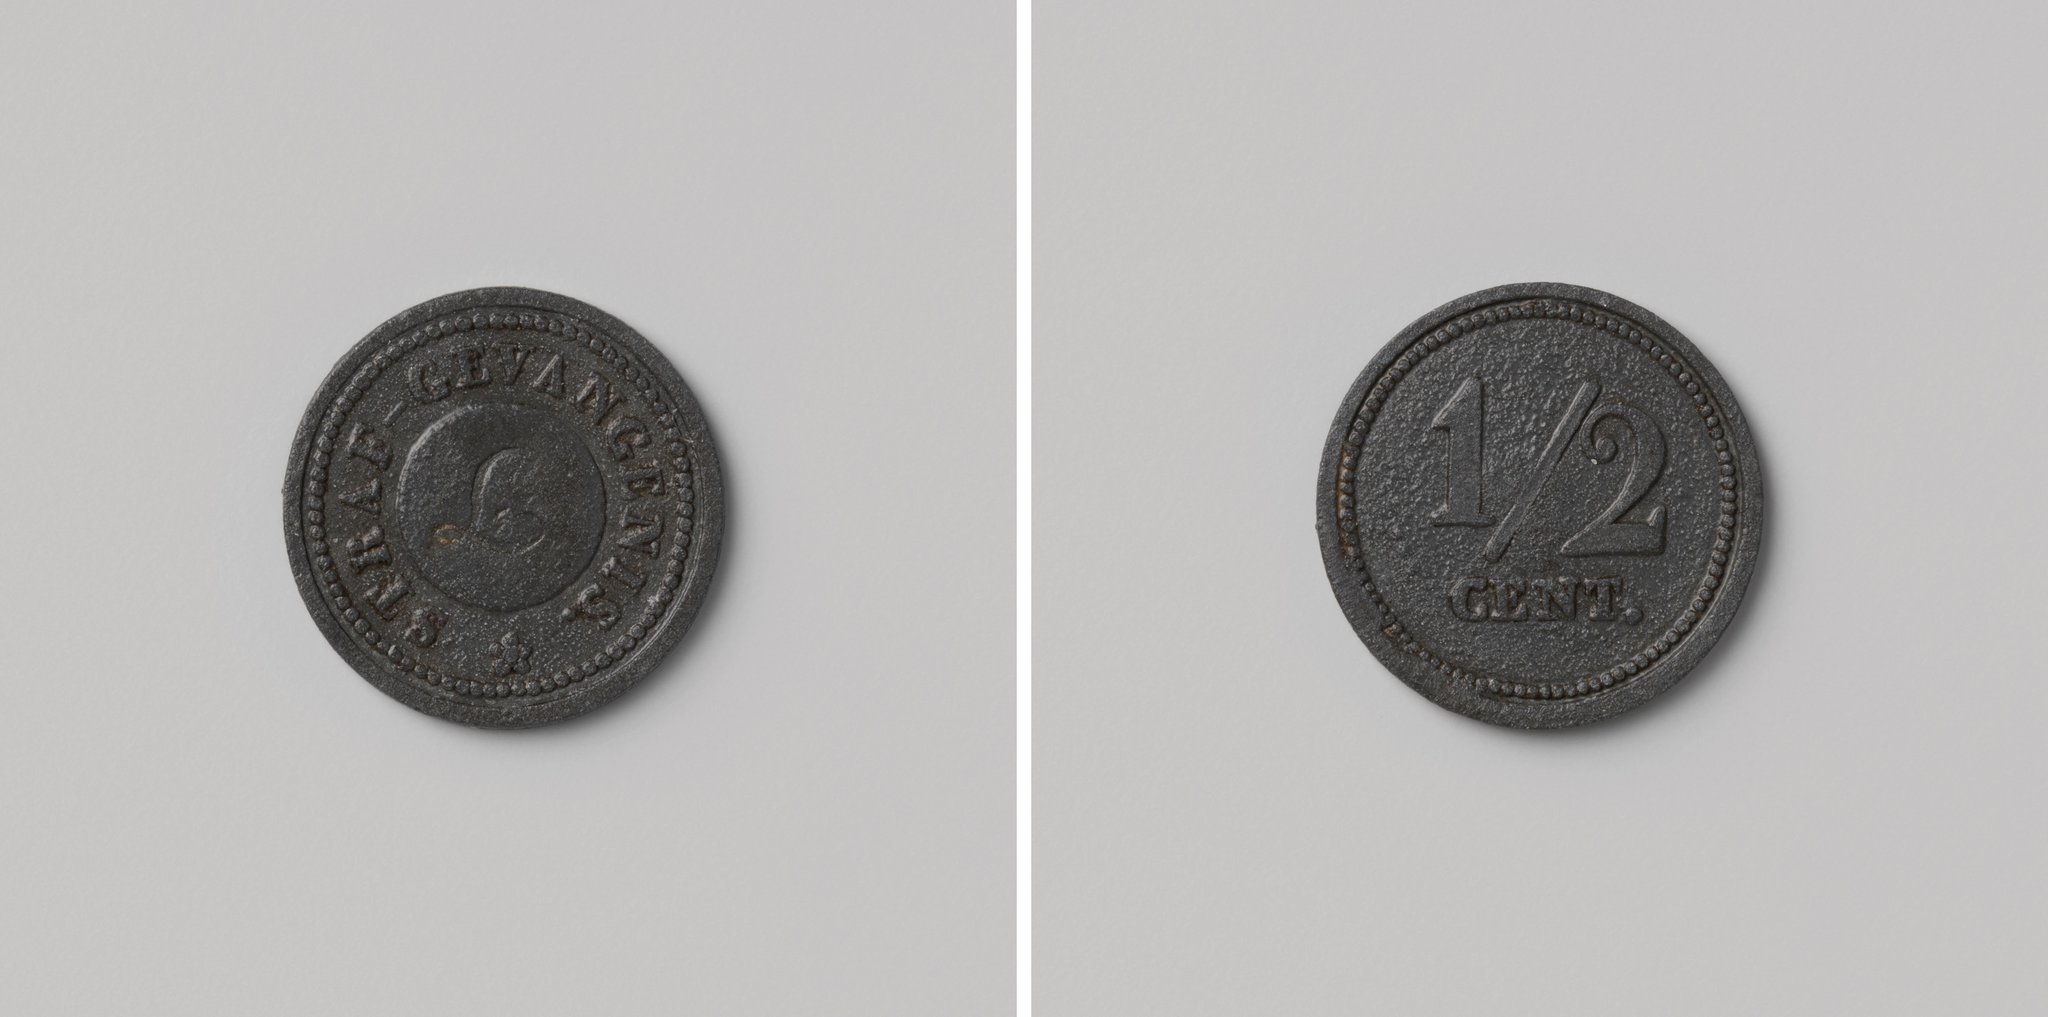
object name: halve cent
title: Strafgevangenis te Leeuwarden, huismunt ter waarde van een halve cent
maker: Anonymous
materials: zinc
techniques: striking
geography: utrecht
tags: leeuwarden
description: Zinken betaalpenning. Voorzijde: letter L binnen omschrift. Keerzijde: waardeaanduiding